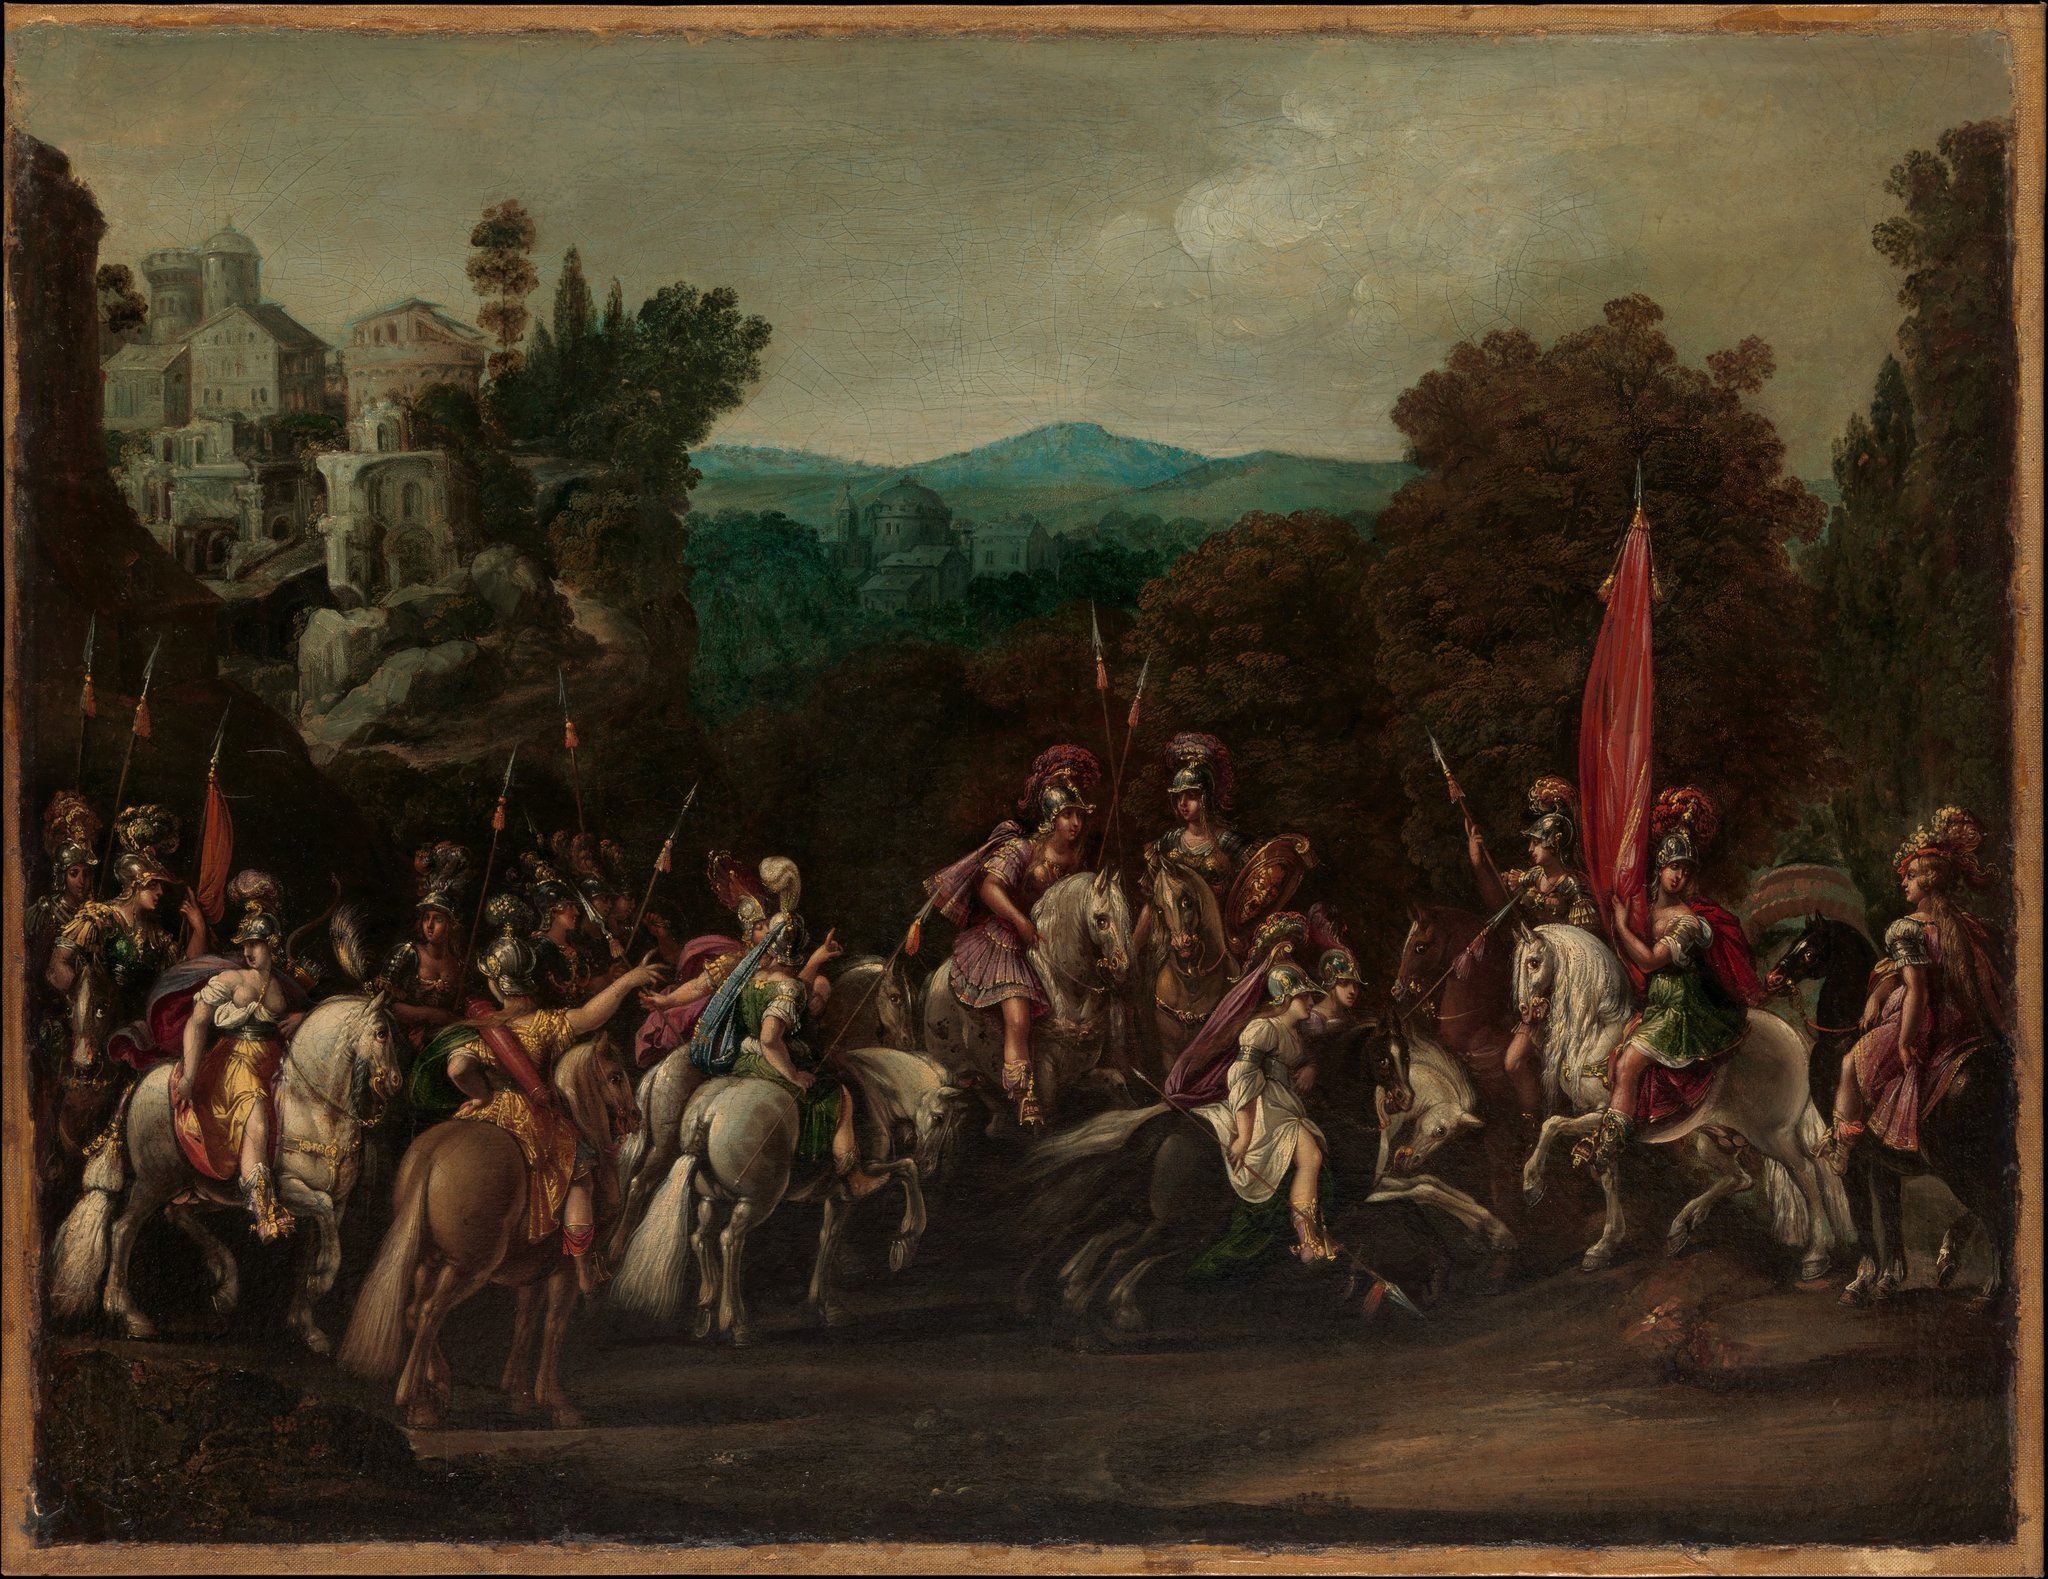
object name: painting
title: Departure of the Amazons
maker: claude déruet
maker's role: artist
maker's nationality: french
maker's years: 1583-1660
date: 1620-1629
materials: canvas, oil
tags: women,amazons,horses,landscapes